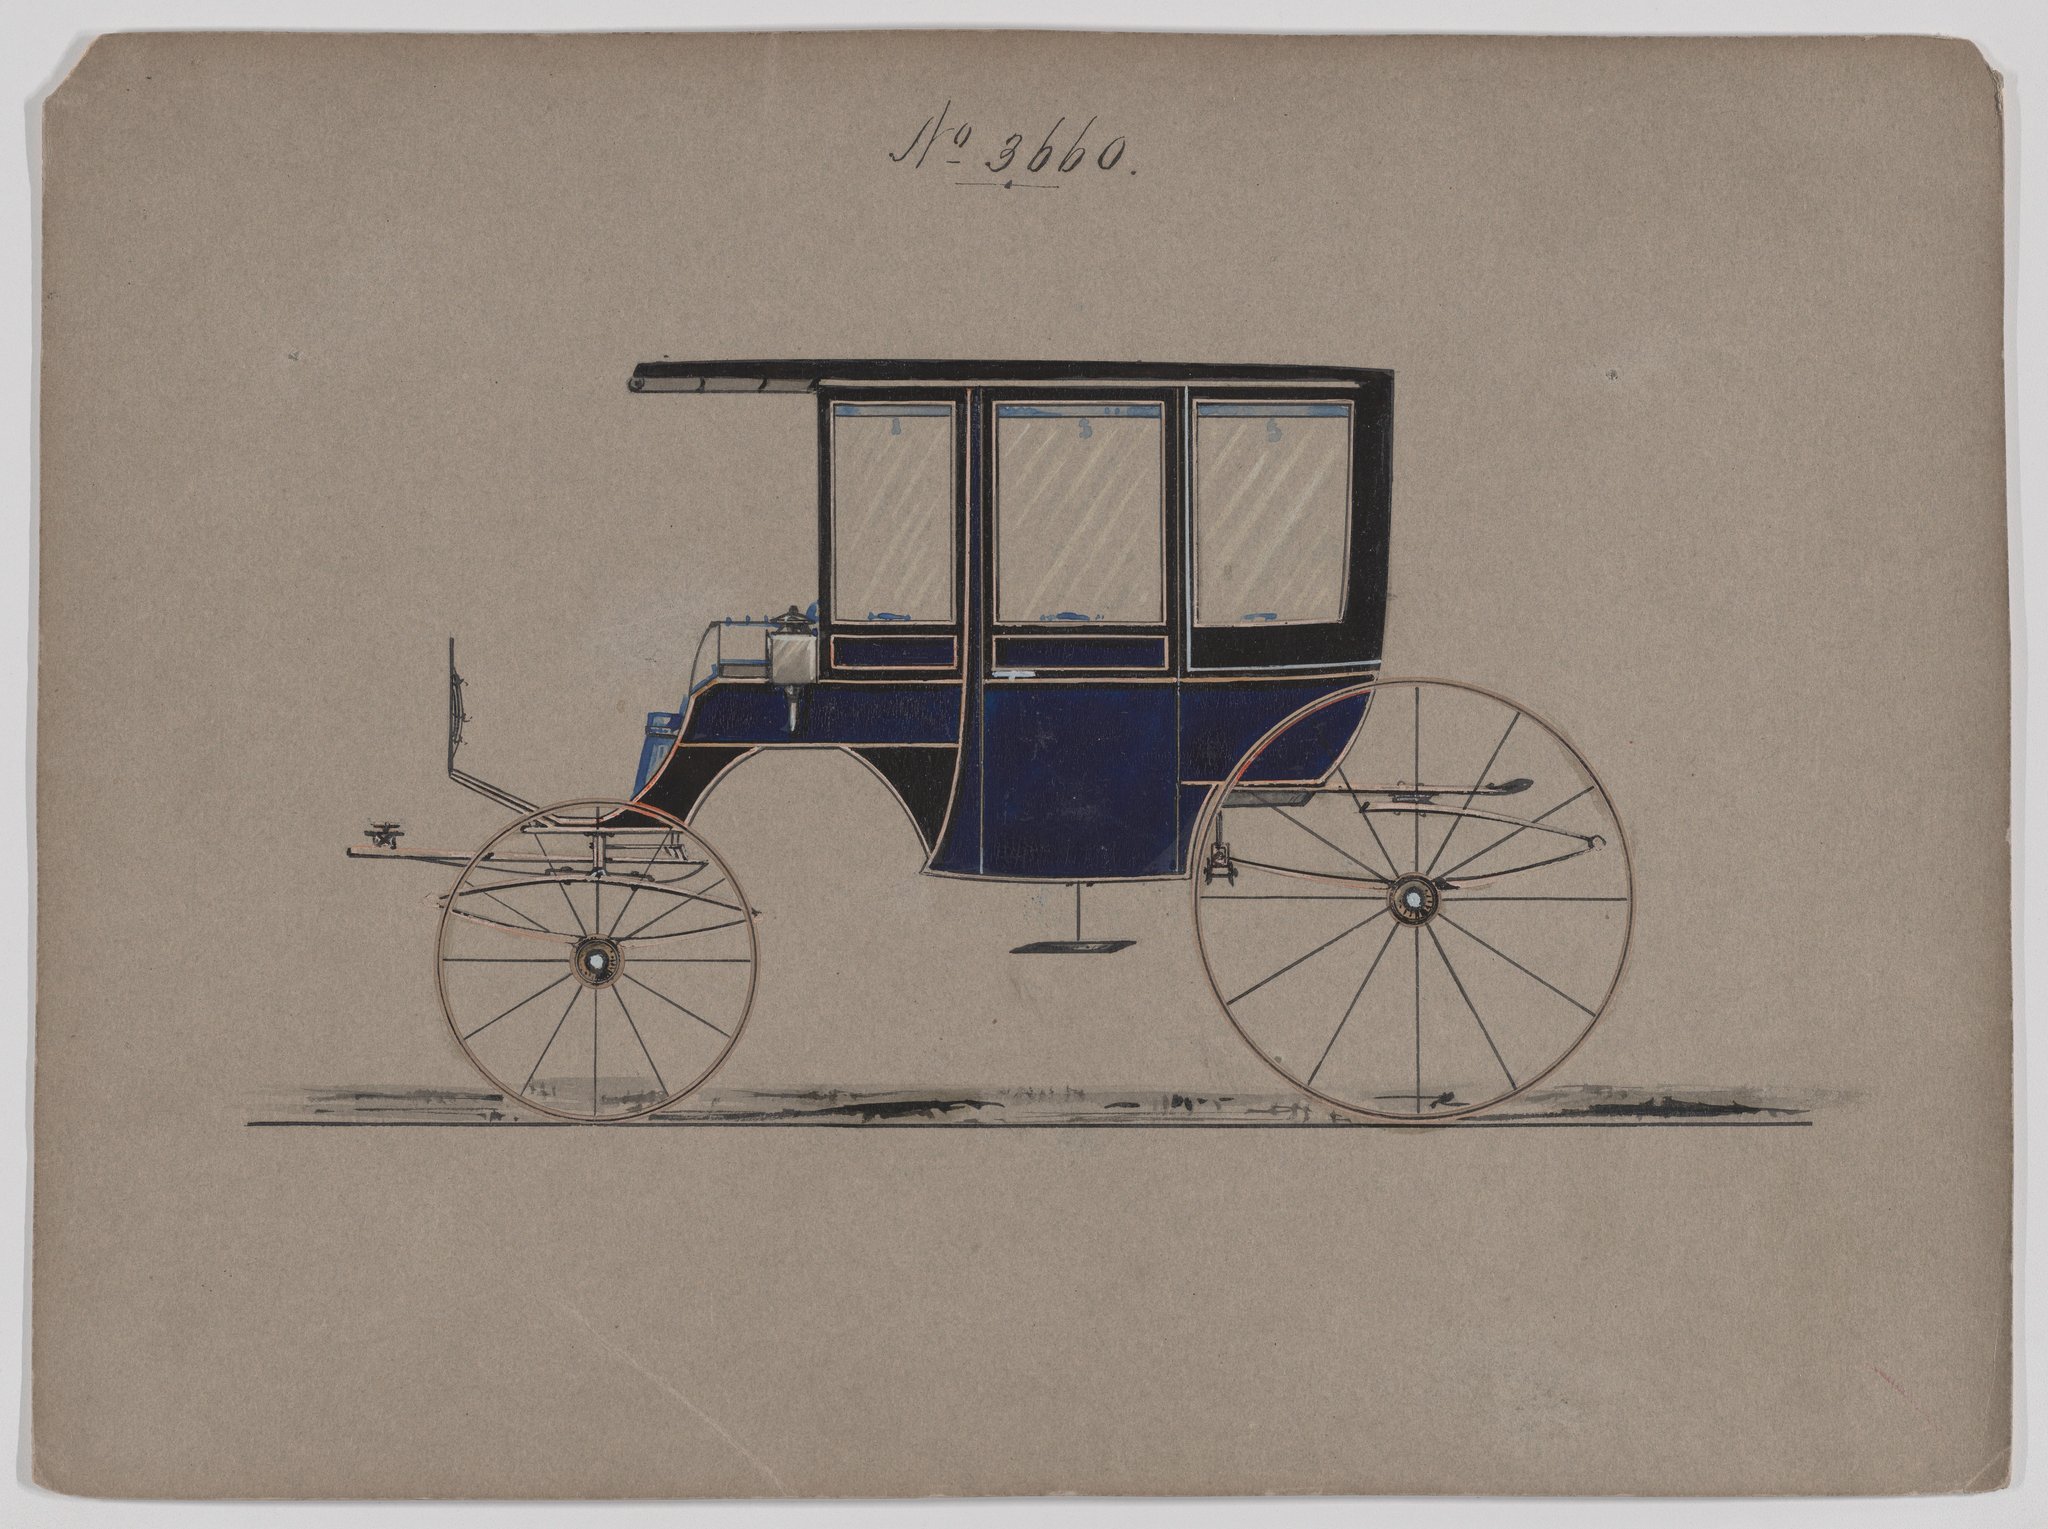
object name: drawing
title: Design for 6 seat Rockaway, no. 3660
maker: brewster & co.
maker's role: manufacturer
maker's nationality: american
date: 1881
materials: gouache, gum arabic, ink, watercolor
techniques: pen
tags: carriages